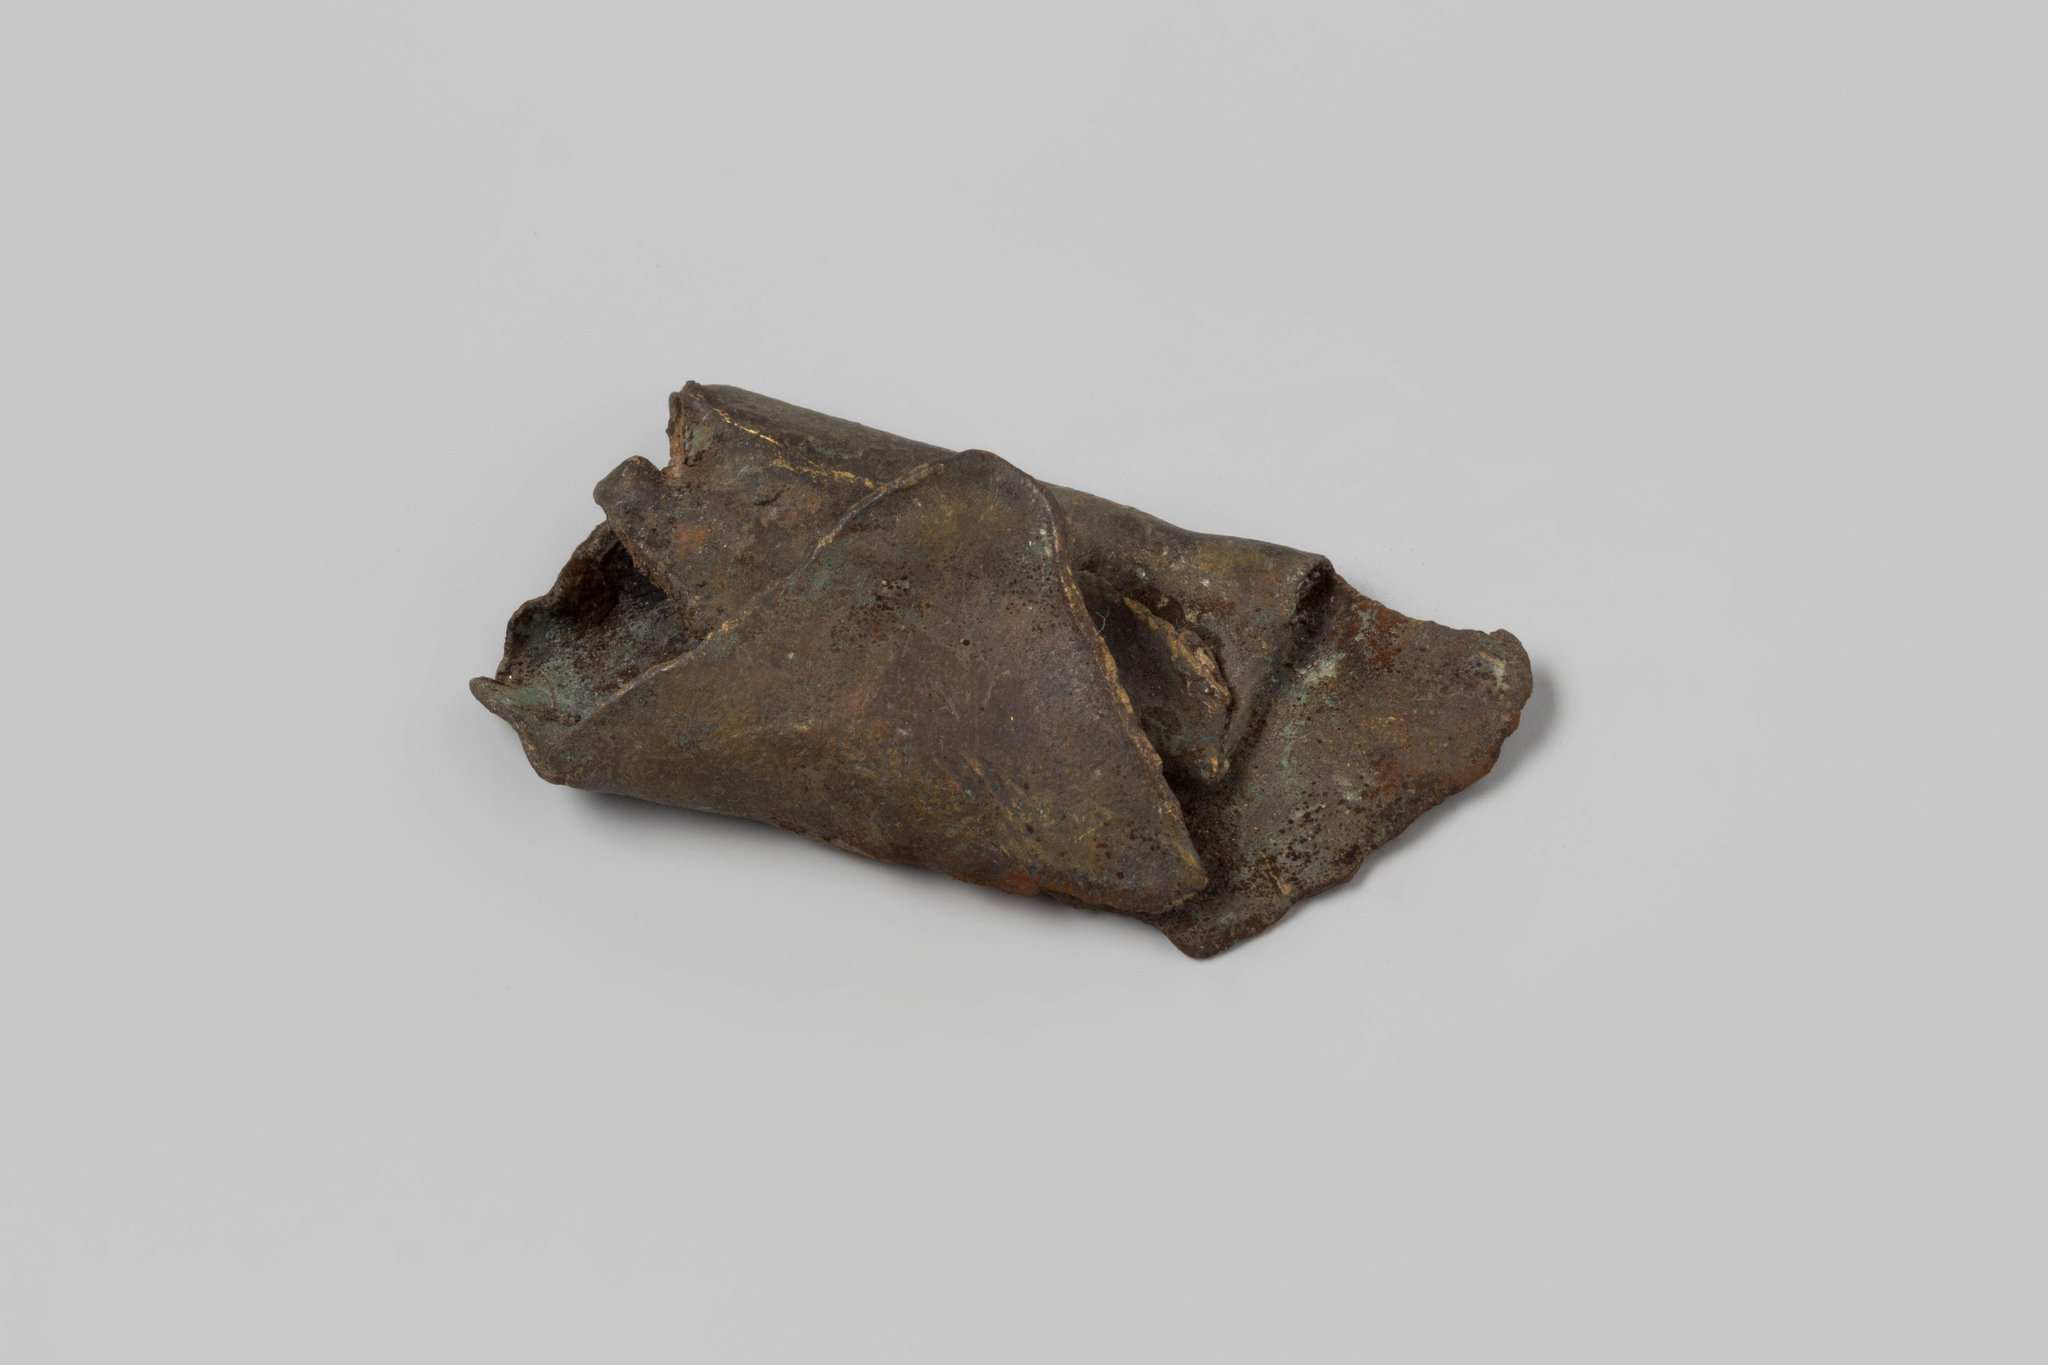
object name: fragment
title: Fragment koper uit het wrak van de Oost-Indiëvaarder Hollandia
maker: Anonymous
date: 1700-1743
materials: copper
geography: netherlands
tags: verenigde oostindische compagnie, hollandia (schip), annet